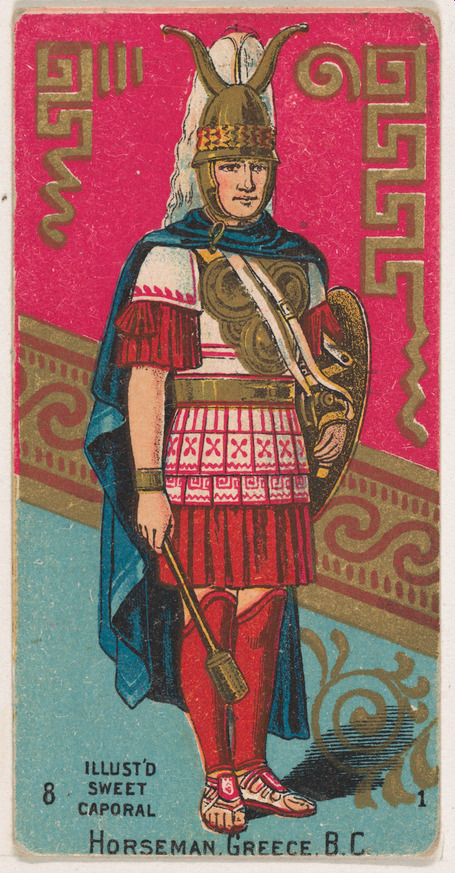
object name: print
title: Horseman, Greece, B.C., from the Military Series (N224) issued by Kinney Tobacco Company to promote Sweet Caporal Cigarettes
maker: kinney brothers tobacco company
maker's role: publisher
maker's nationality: american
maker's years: 1869-2011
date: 1888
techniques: color lithograph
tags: military,men